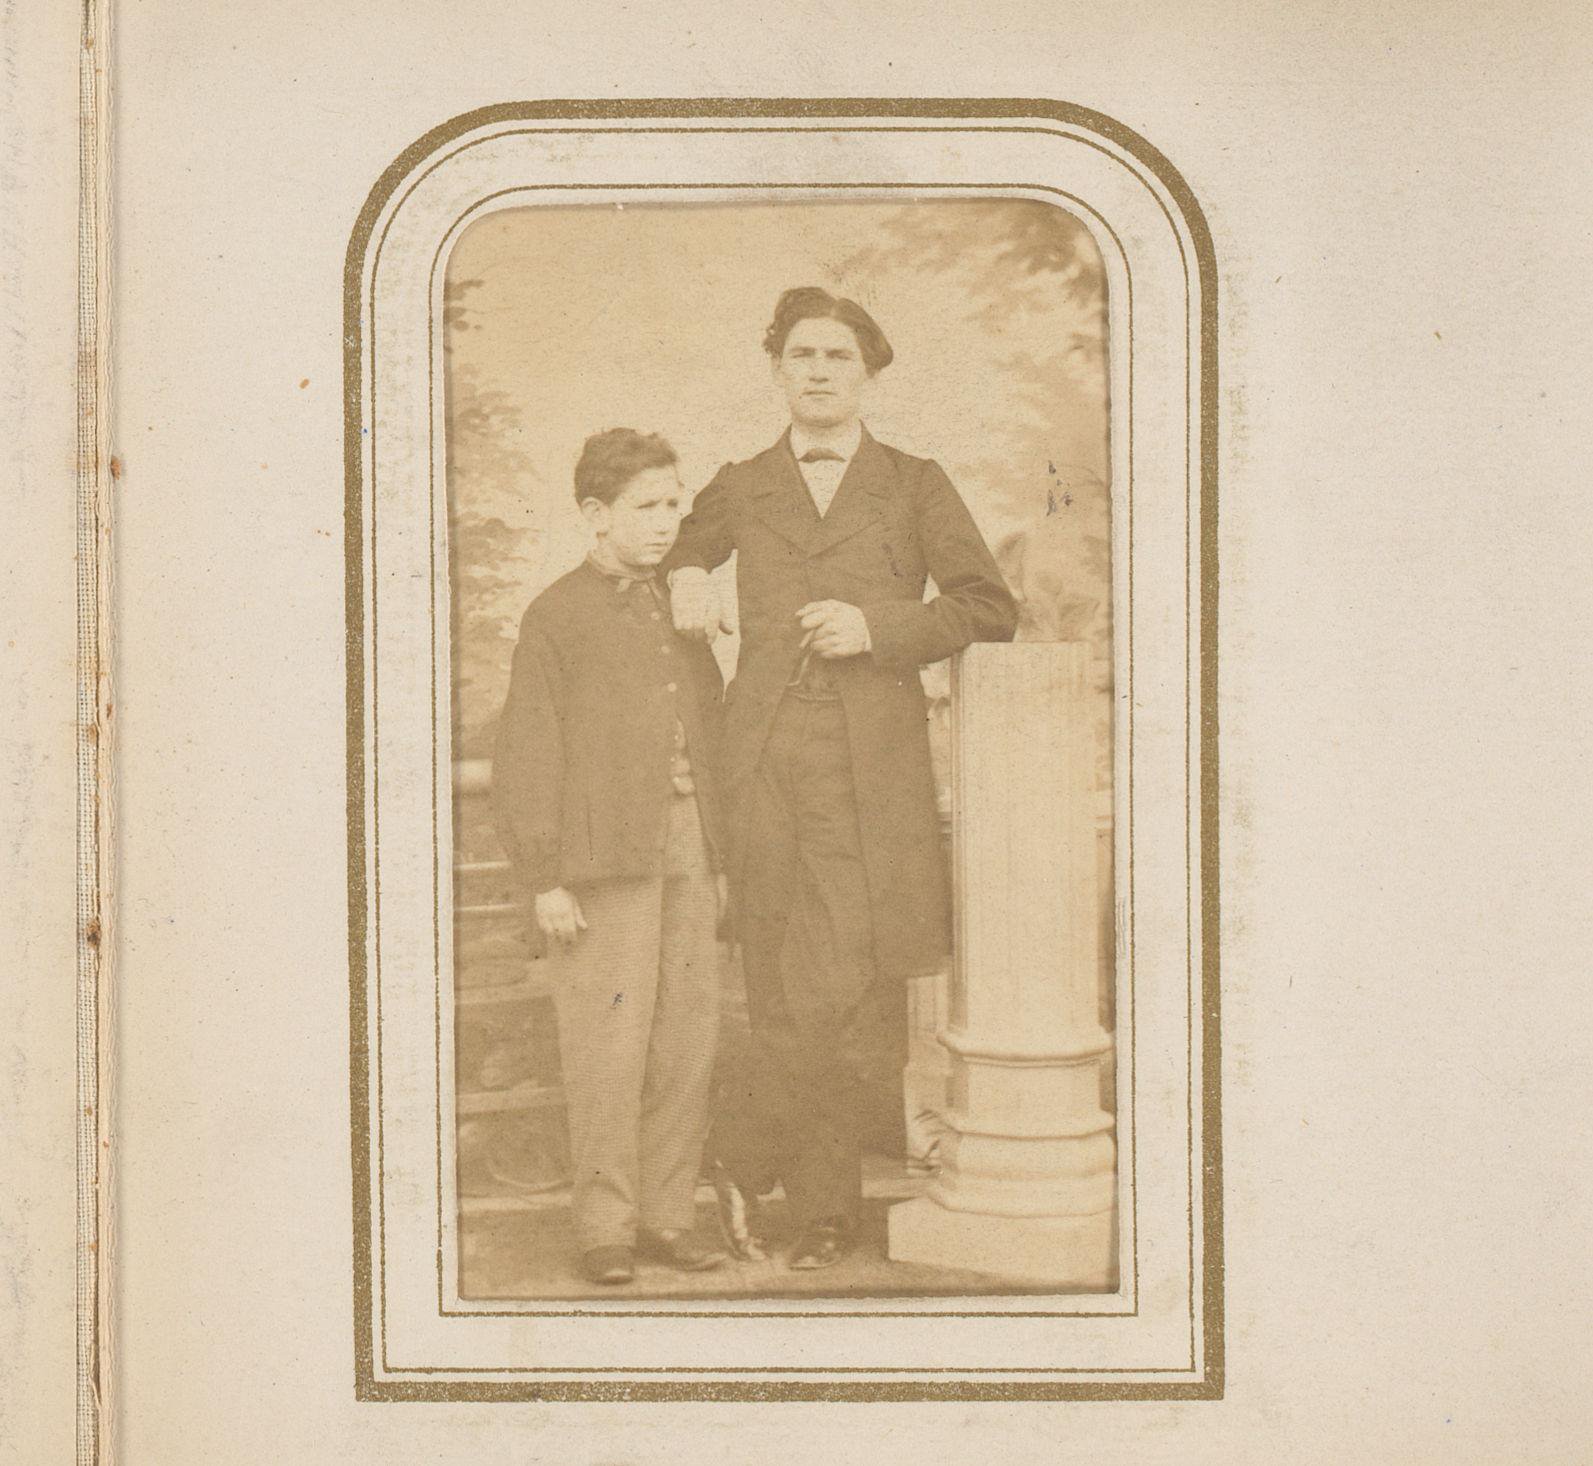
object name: slip in album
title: Frans fotoalbum met 45 portretten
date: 1860-1900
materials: cardboard, leather, metal, photographic support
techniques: albumen print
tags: adult woman, adult man, child, historical persons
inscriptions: retailer's mark: ‘Asser & Sherwin/ Makers/ 81 Strand/ London’, inscription: ‘Dienst/ Verspreide/ Rijkskollekties (...)’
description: Fotoalbum met 50 pagina's met in totaal 45 foto's, alle cartes-de-visite. Het album bevat portretten van mannen, vrouwen en kinderen en amateurfoto's.